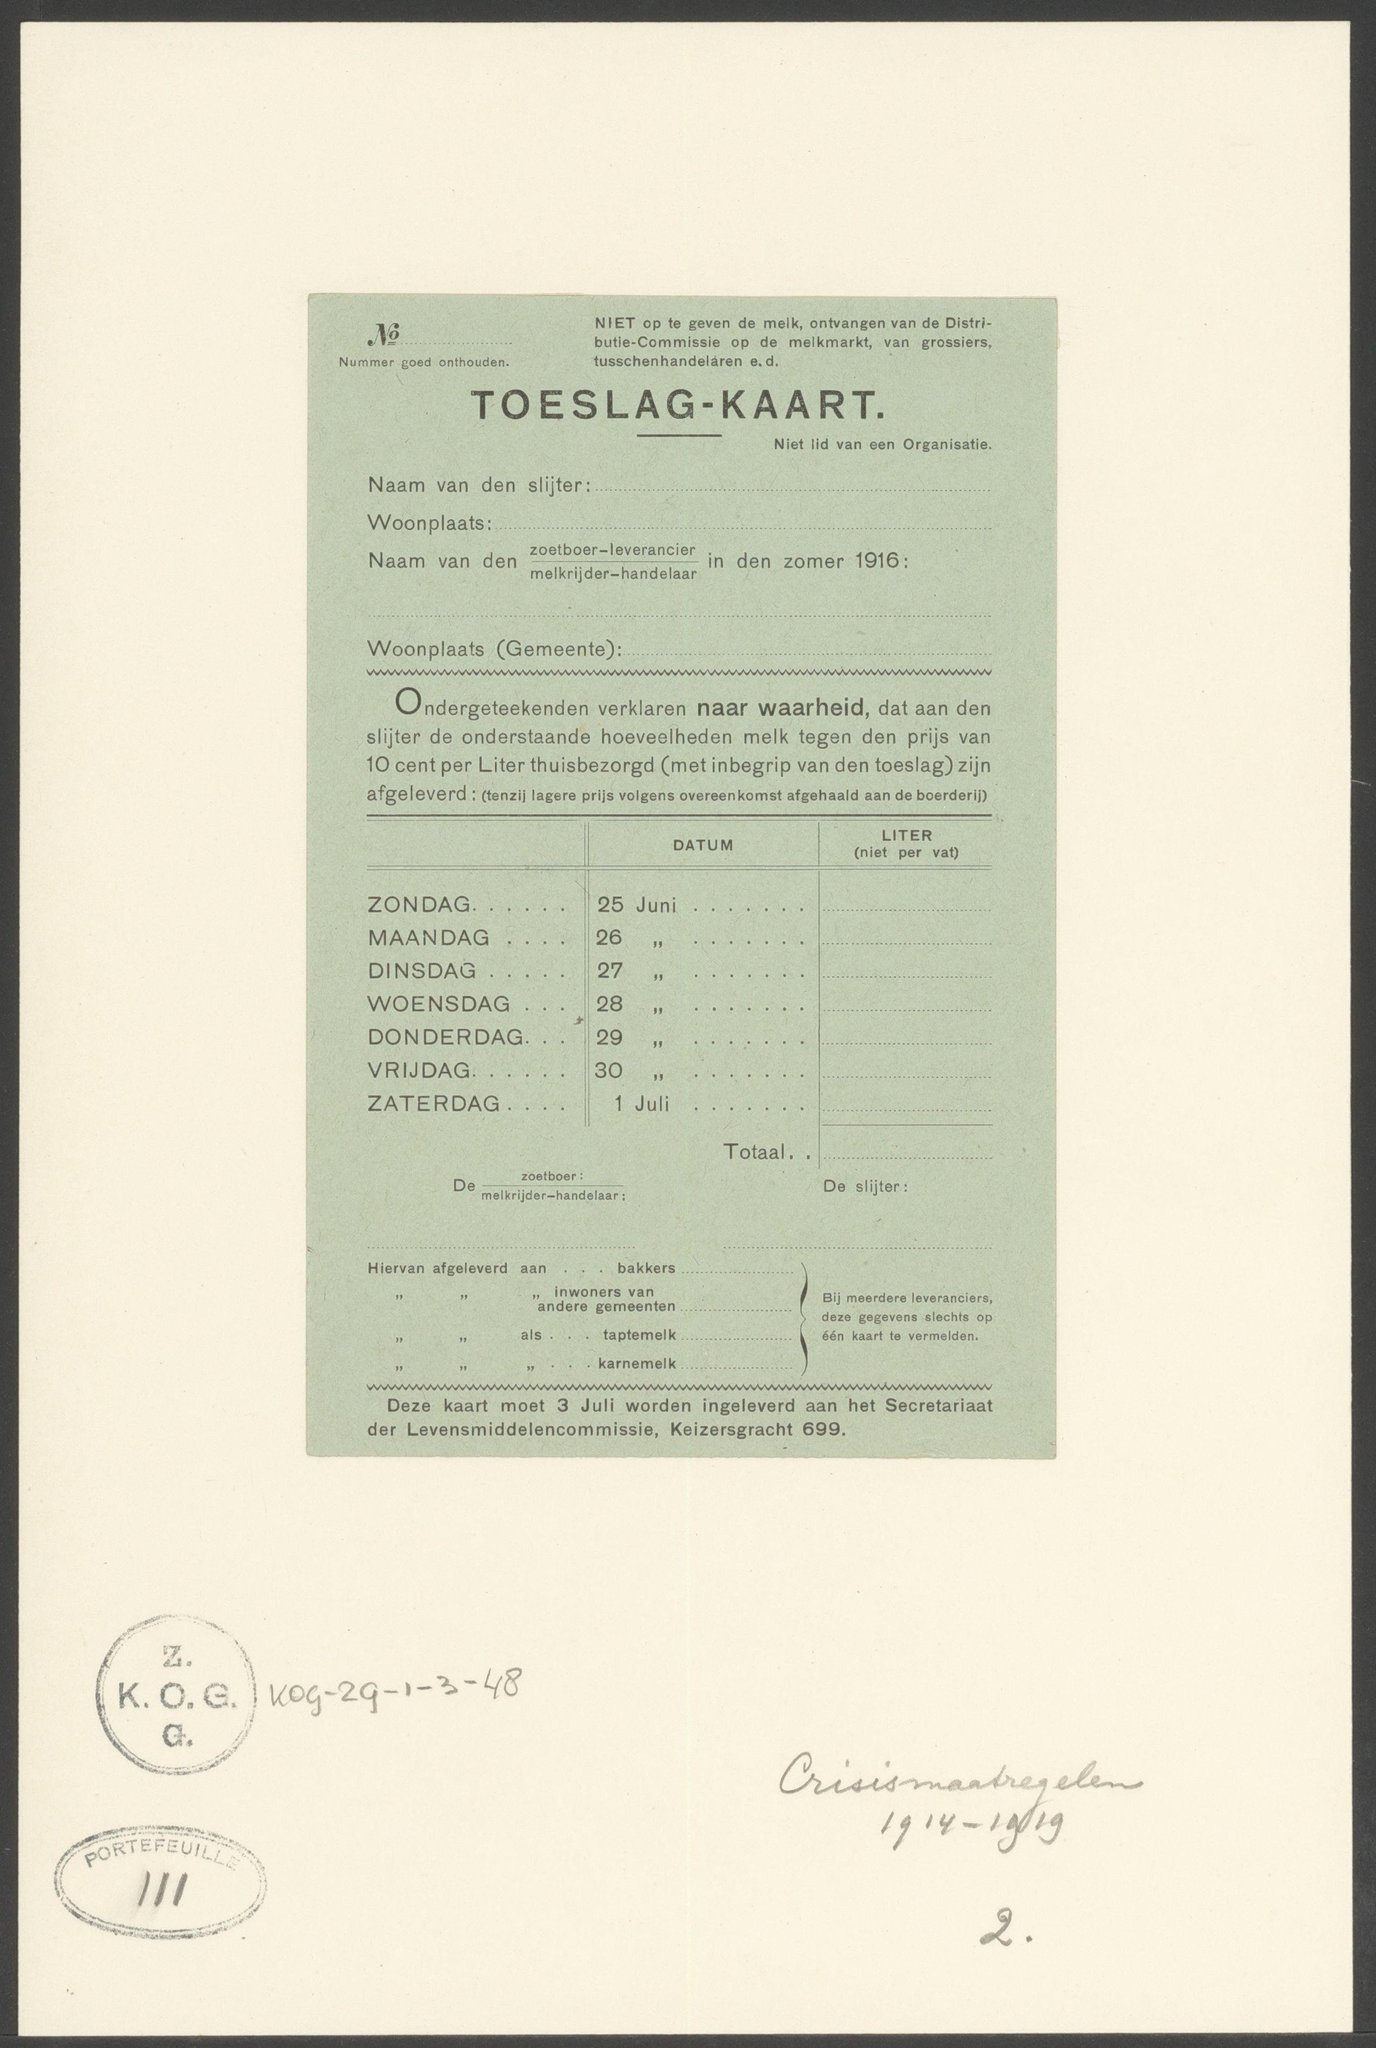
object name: document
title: Toeslagkaart voor de melkslijter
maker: Anonymous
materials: paper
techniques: letterpress printing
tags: amsterdam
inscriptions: collector's mark: Lugt 1641, stamp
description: Toeslagkaart voor de melkslijter voor juni 1916. Tijdens de Eerste Wereldoorlog houdt de regering prijzen van bepaalde voedingsmiddelen kunstmatig laag. Met deze toeslagkaart geeft de melkslijter aan hoeveel melk afgeleverd is aan bakkers en inwoners van de stad Amsterdam. Onderwerpsrubrieken binnen de Atlas Zeden en Gewoonten: Regeering, Crisismaatregelen gedurende den wereldoorlog 1914-1919.